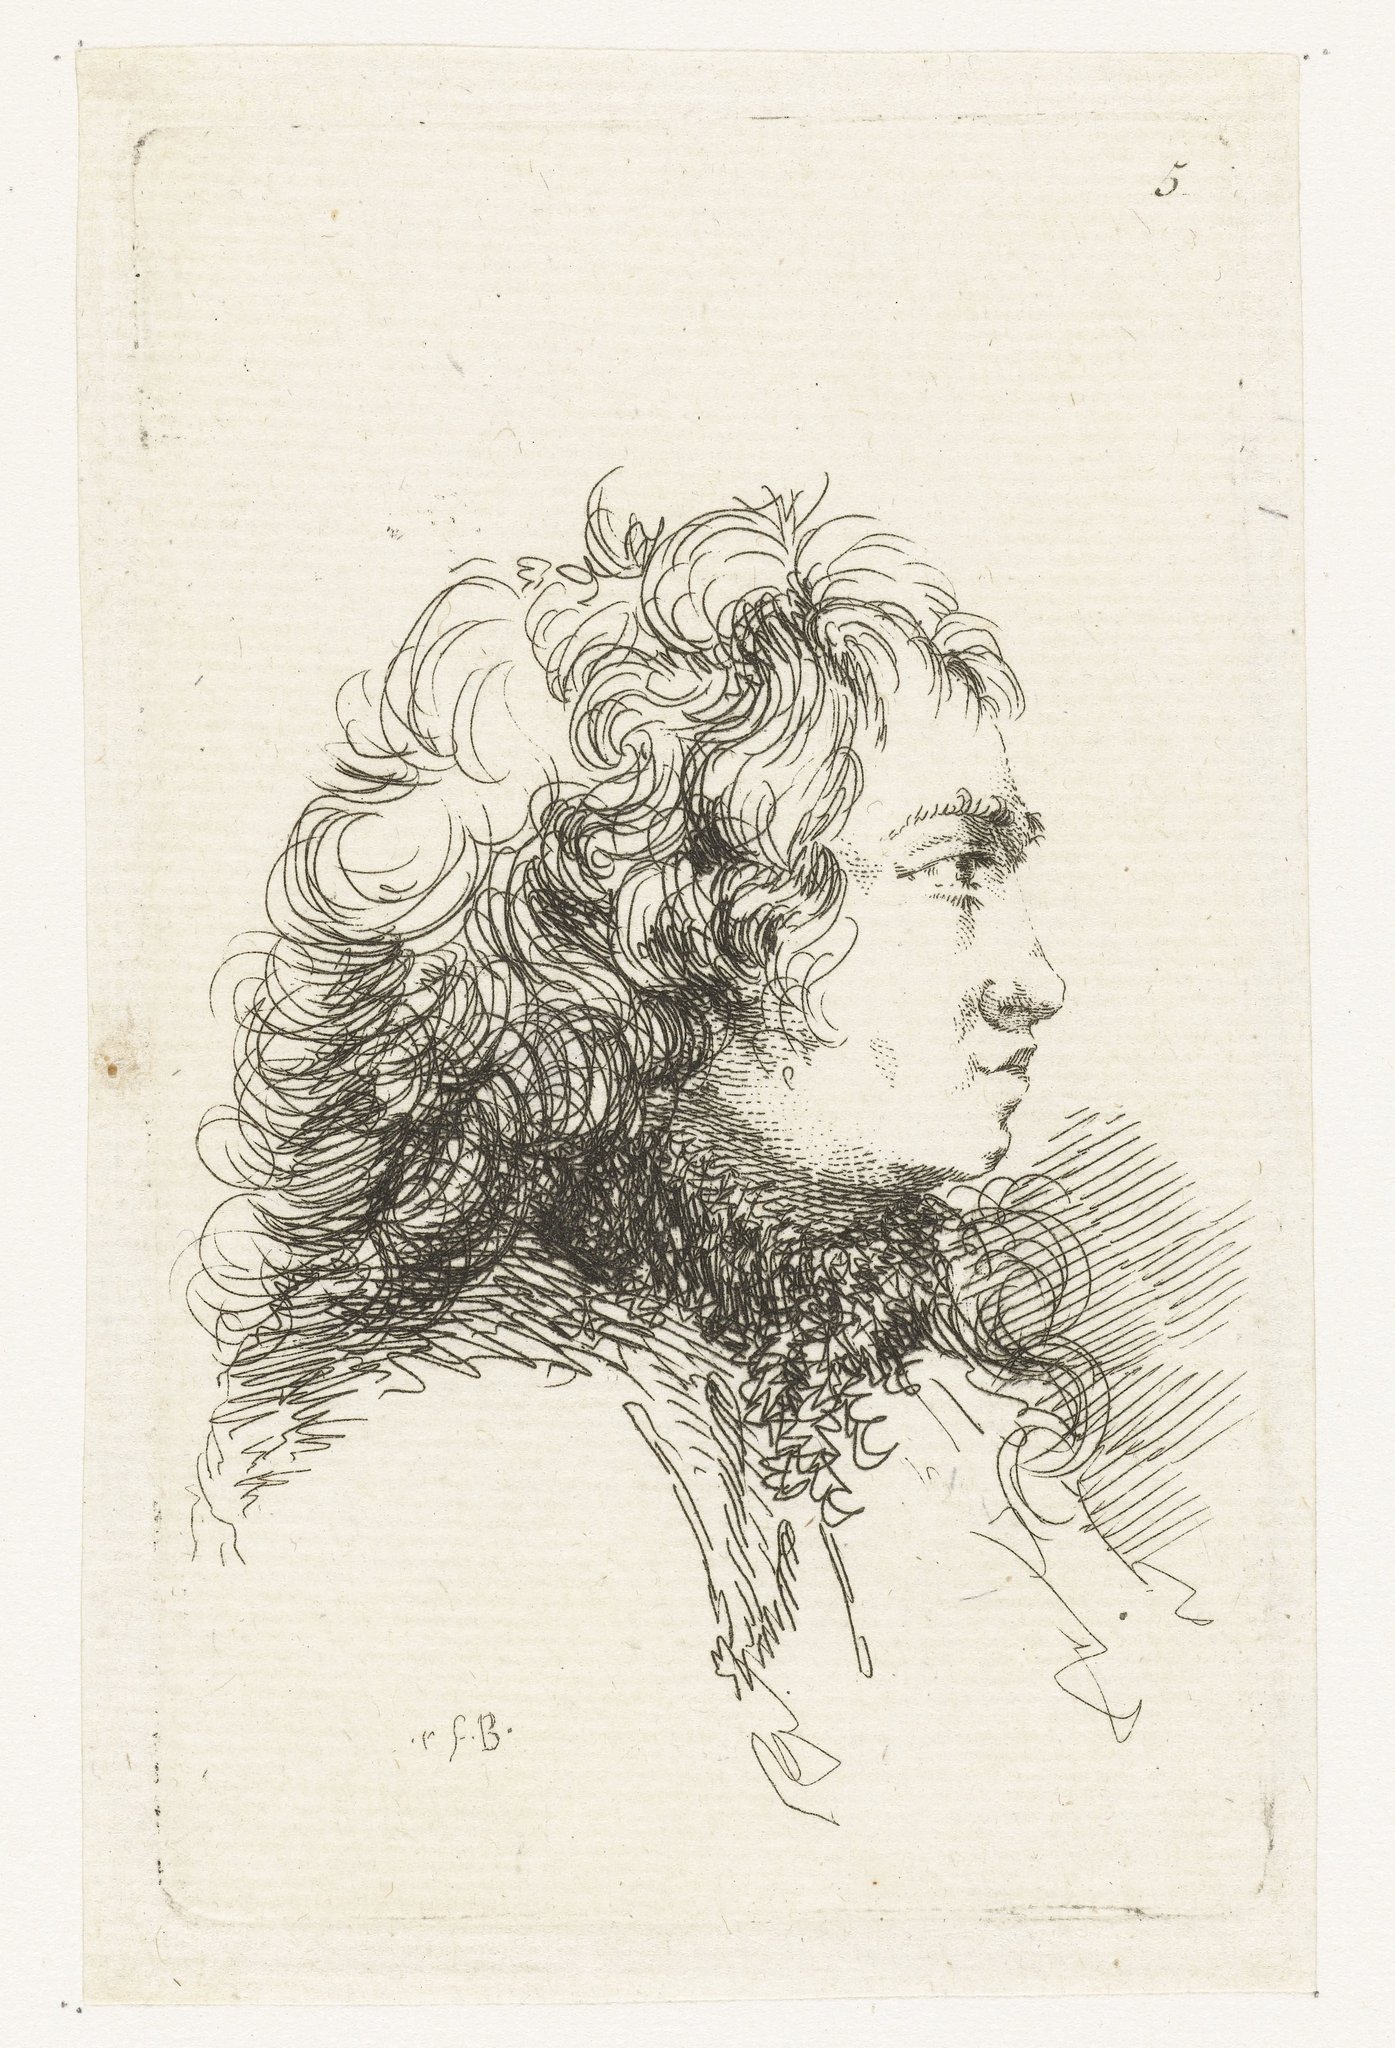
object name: print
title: Suite van kleine genrestukjes en koppen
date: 1727-1755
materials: paper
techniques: etching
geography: france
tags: youth, adolescent (+ sideview, profile)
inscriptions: collector's mark: Lugt 2760, collector's mark: Lugt 2228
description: Hoofd van een jongeman met lang haar, en profil naar rechts.